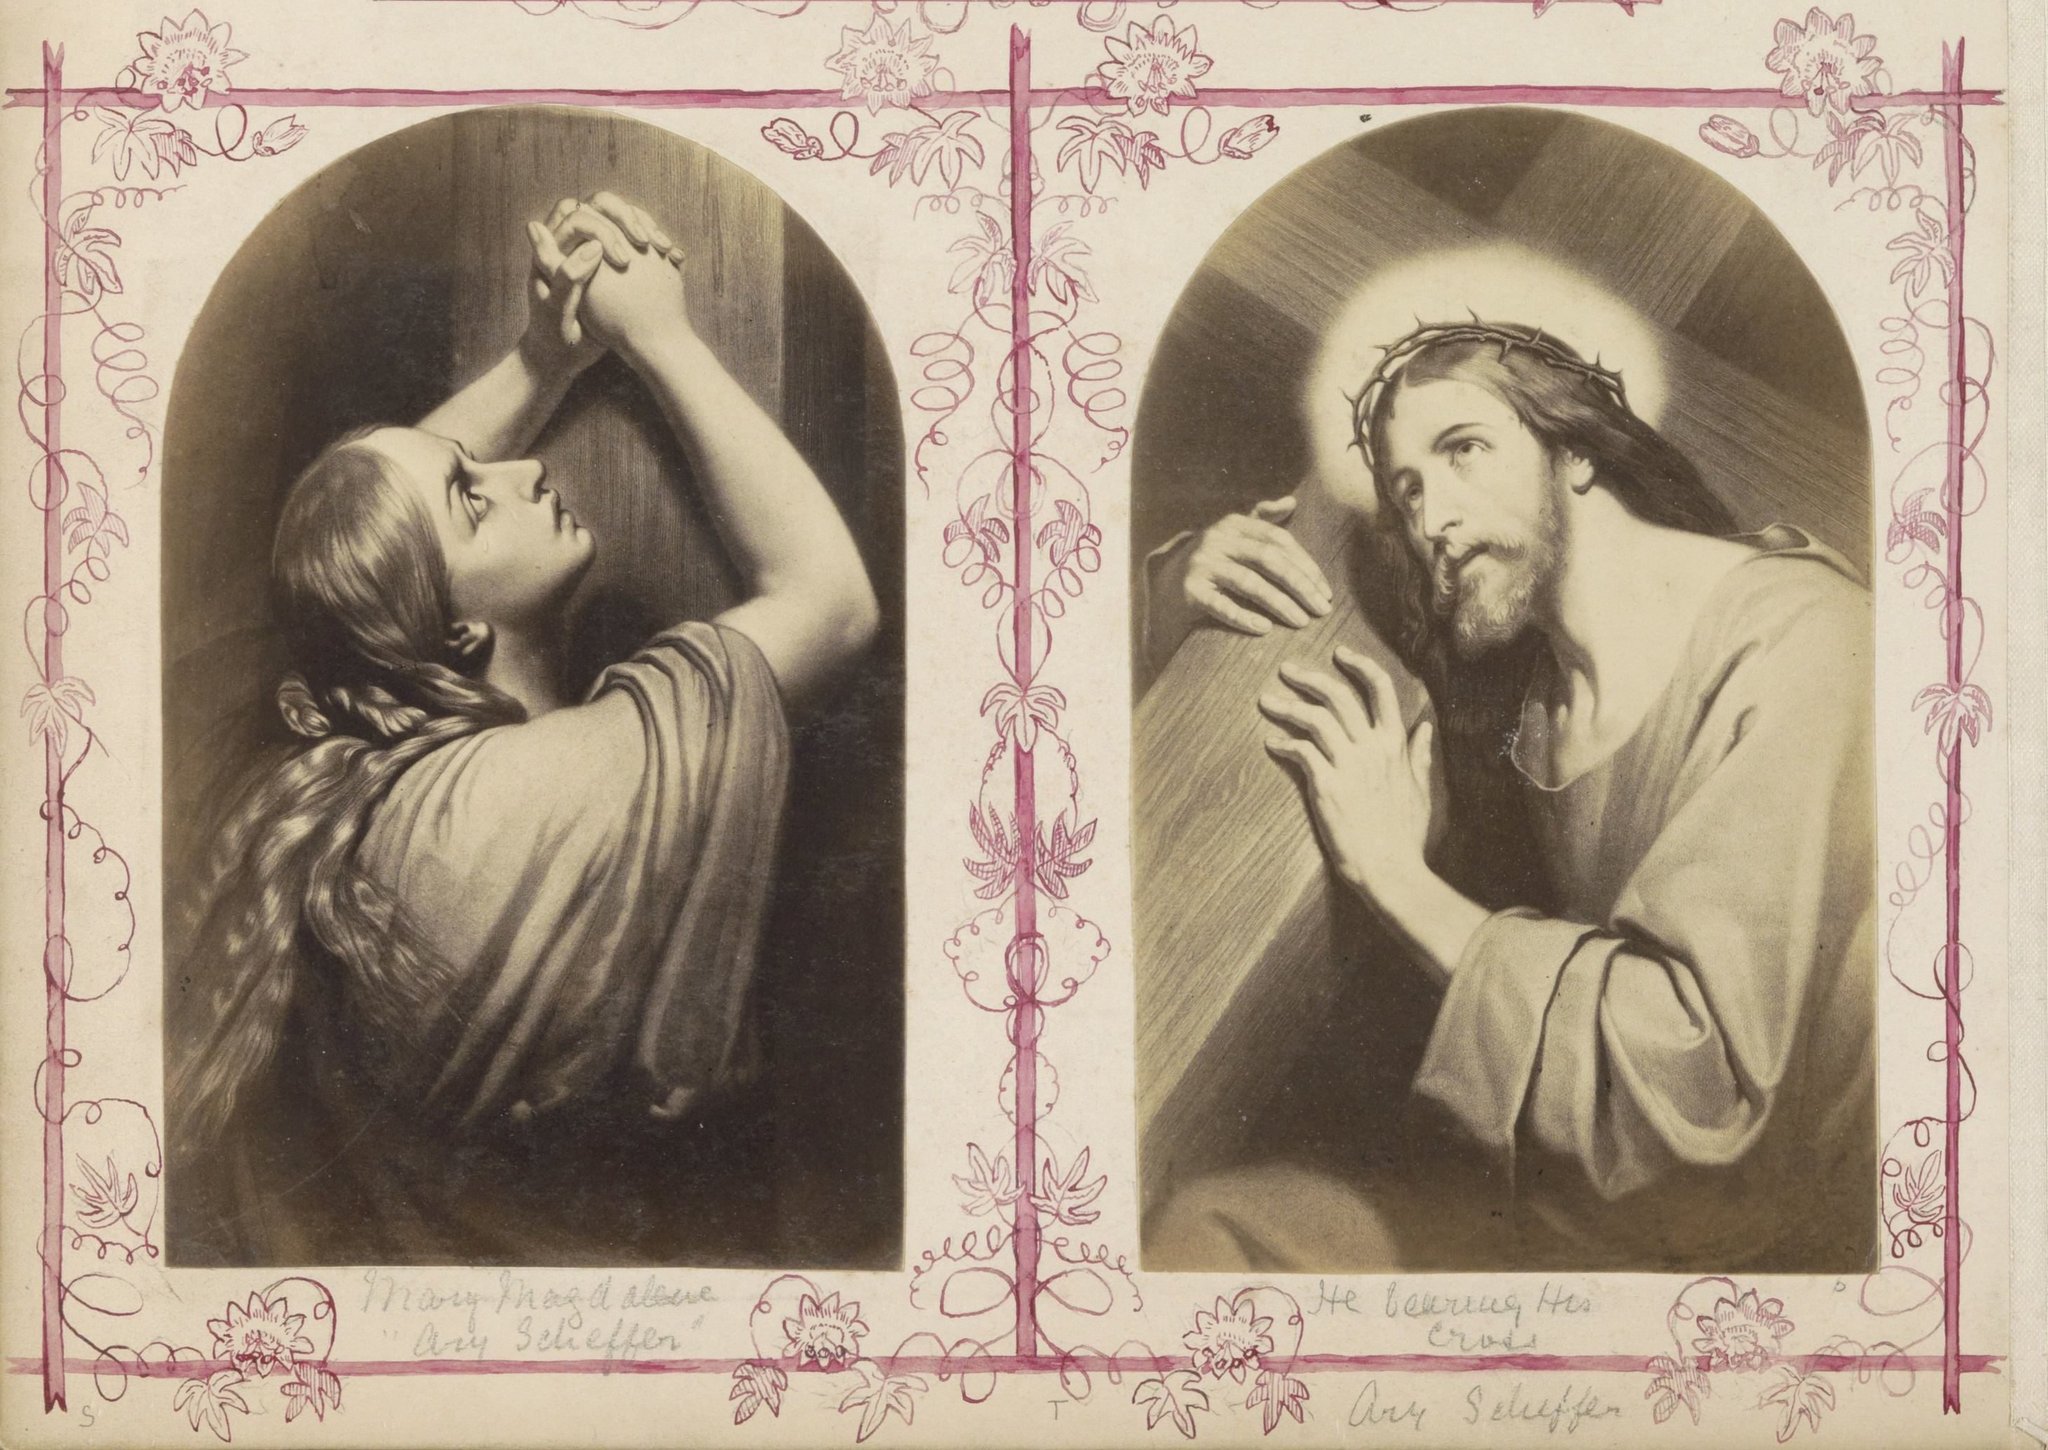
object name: photograph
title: Fotoreproductie van (vermoedelijk) een prent met een kruisdragende Christus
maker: Anonymous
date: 1850-1870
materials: paper, photographic support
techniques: albumen print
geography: england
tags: carrying of the cross: christ bearing the cross, alone or with the help of others (e.g. simon the cyrenian)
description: Onderdeel van Album met foto's van bezienswaardigheden en landschappen in Engeland en van kunst.